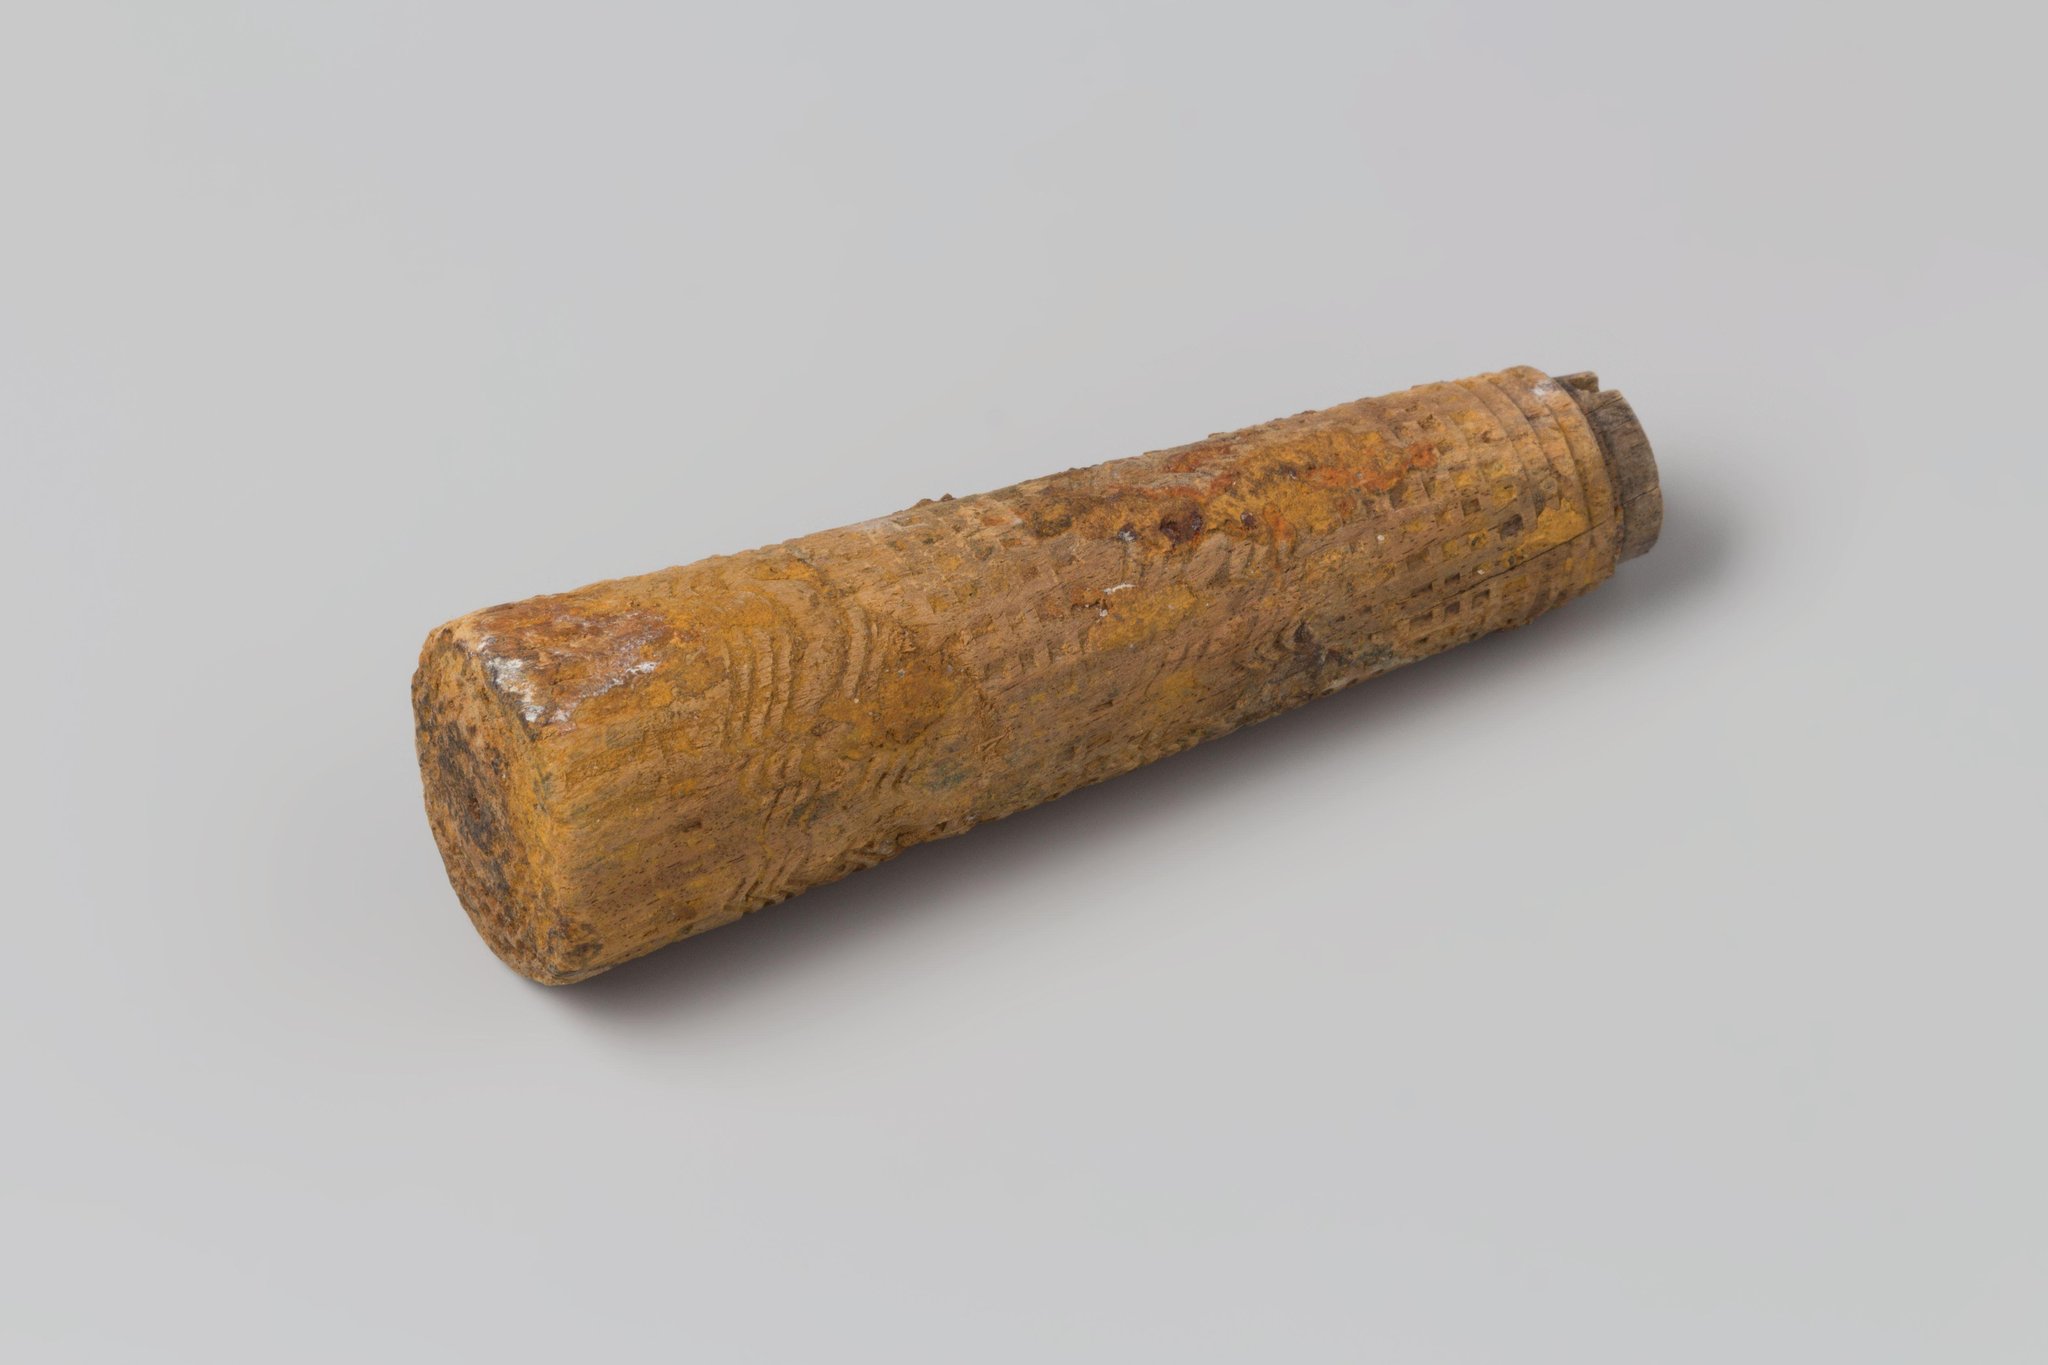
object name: knife handle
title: Messenheft uit het wrak van de Oost-Indiëvaarder Hollandia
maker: Anonymous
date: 1700-1743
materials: wood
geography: netherlands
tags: verenigde oostindische compagnie, hollandia (schip), annet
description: Knife, handle, cylindrical: tapering; id. NG 1979-403H, ferrules, id. NG 1980-27H426.